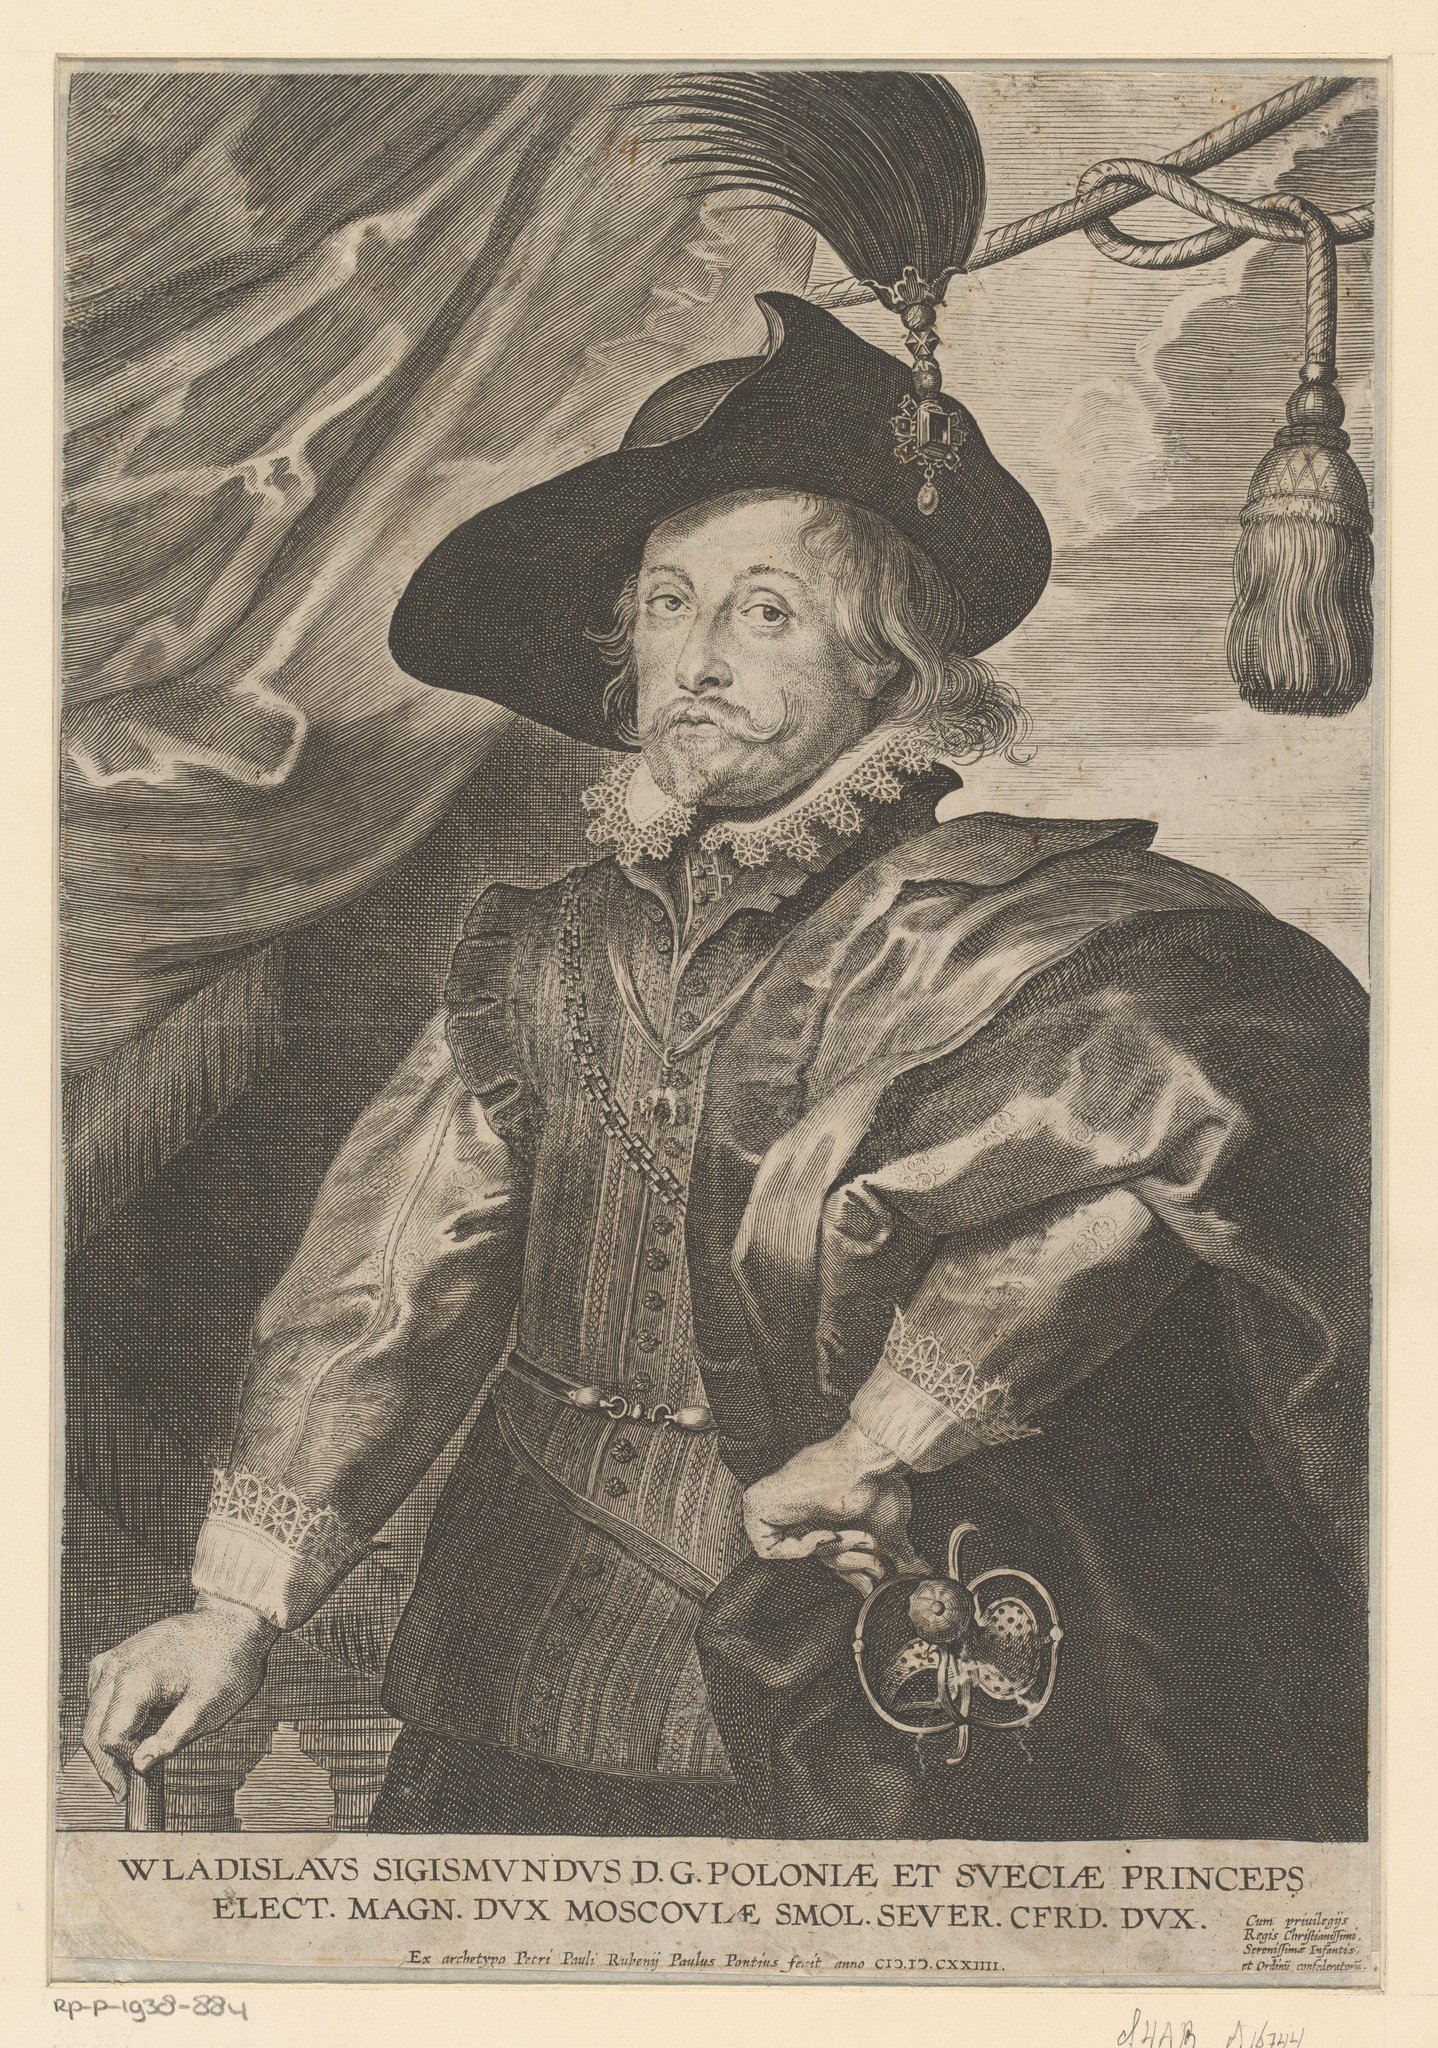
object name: print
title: Portret van Wladislaus IV van Polen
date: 1624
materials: paper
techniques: engraving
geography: antwerp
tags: wladislaus wasa (iv), historical persons, knighthood order of the golden fleece, king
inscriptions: collector's mark: Lugt 2228, privilege: ‘Cum Privilegiis Regis Christianissimi, Serenissimae Infantis et Ordinum Confederatorum’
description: Met tweeregelig onderschrift in het Latijn.